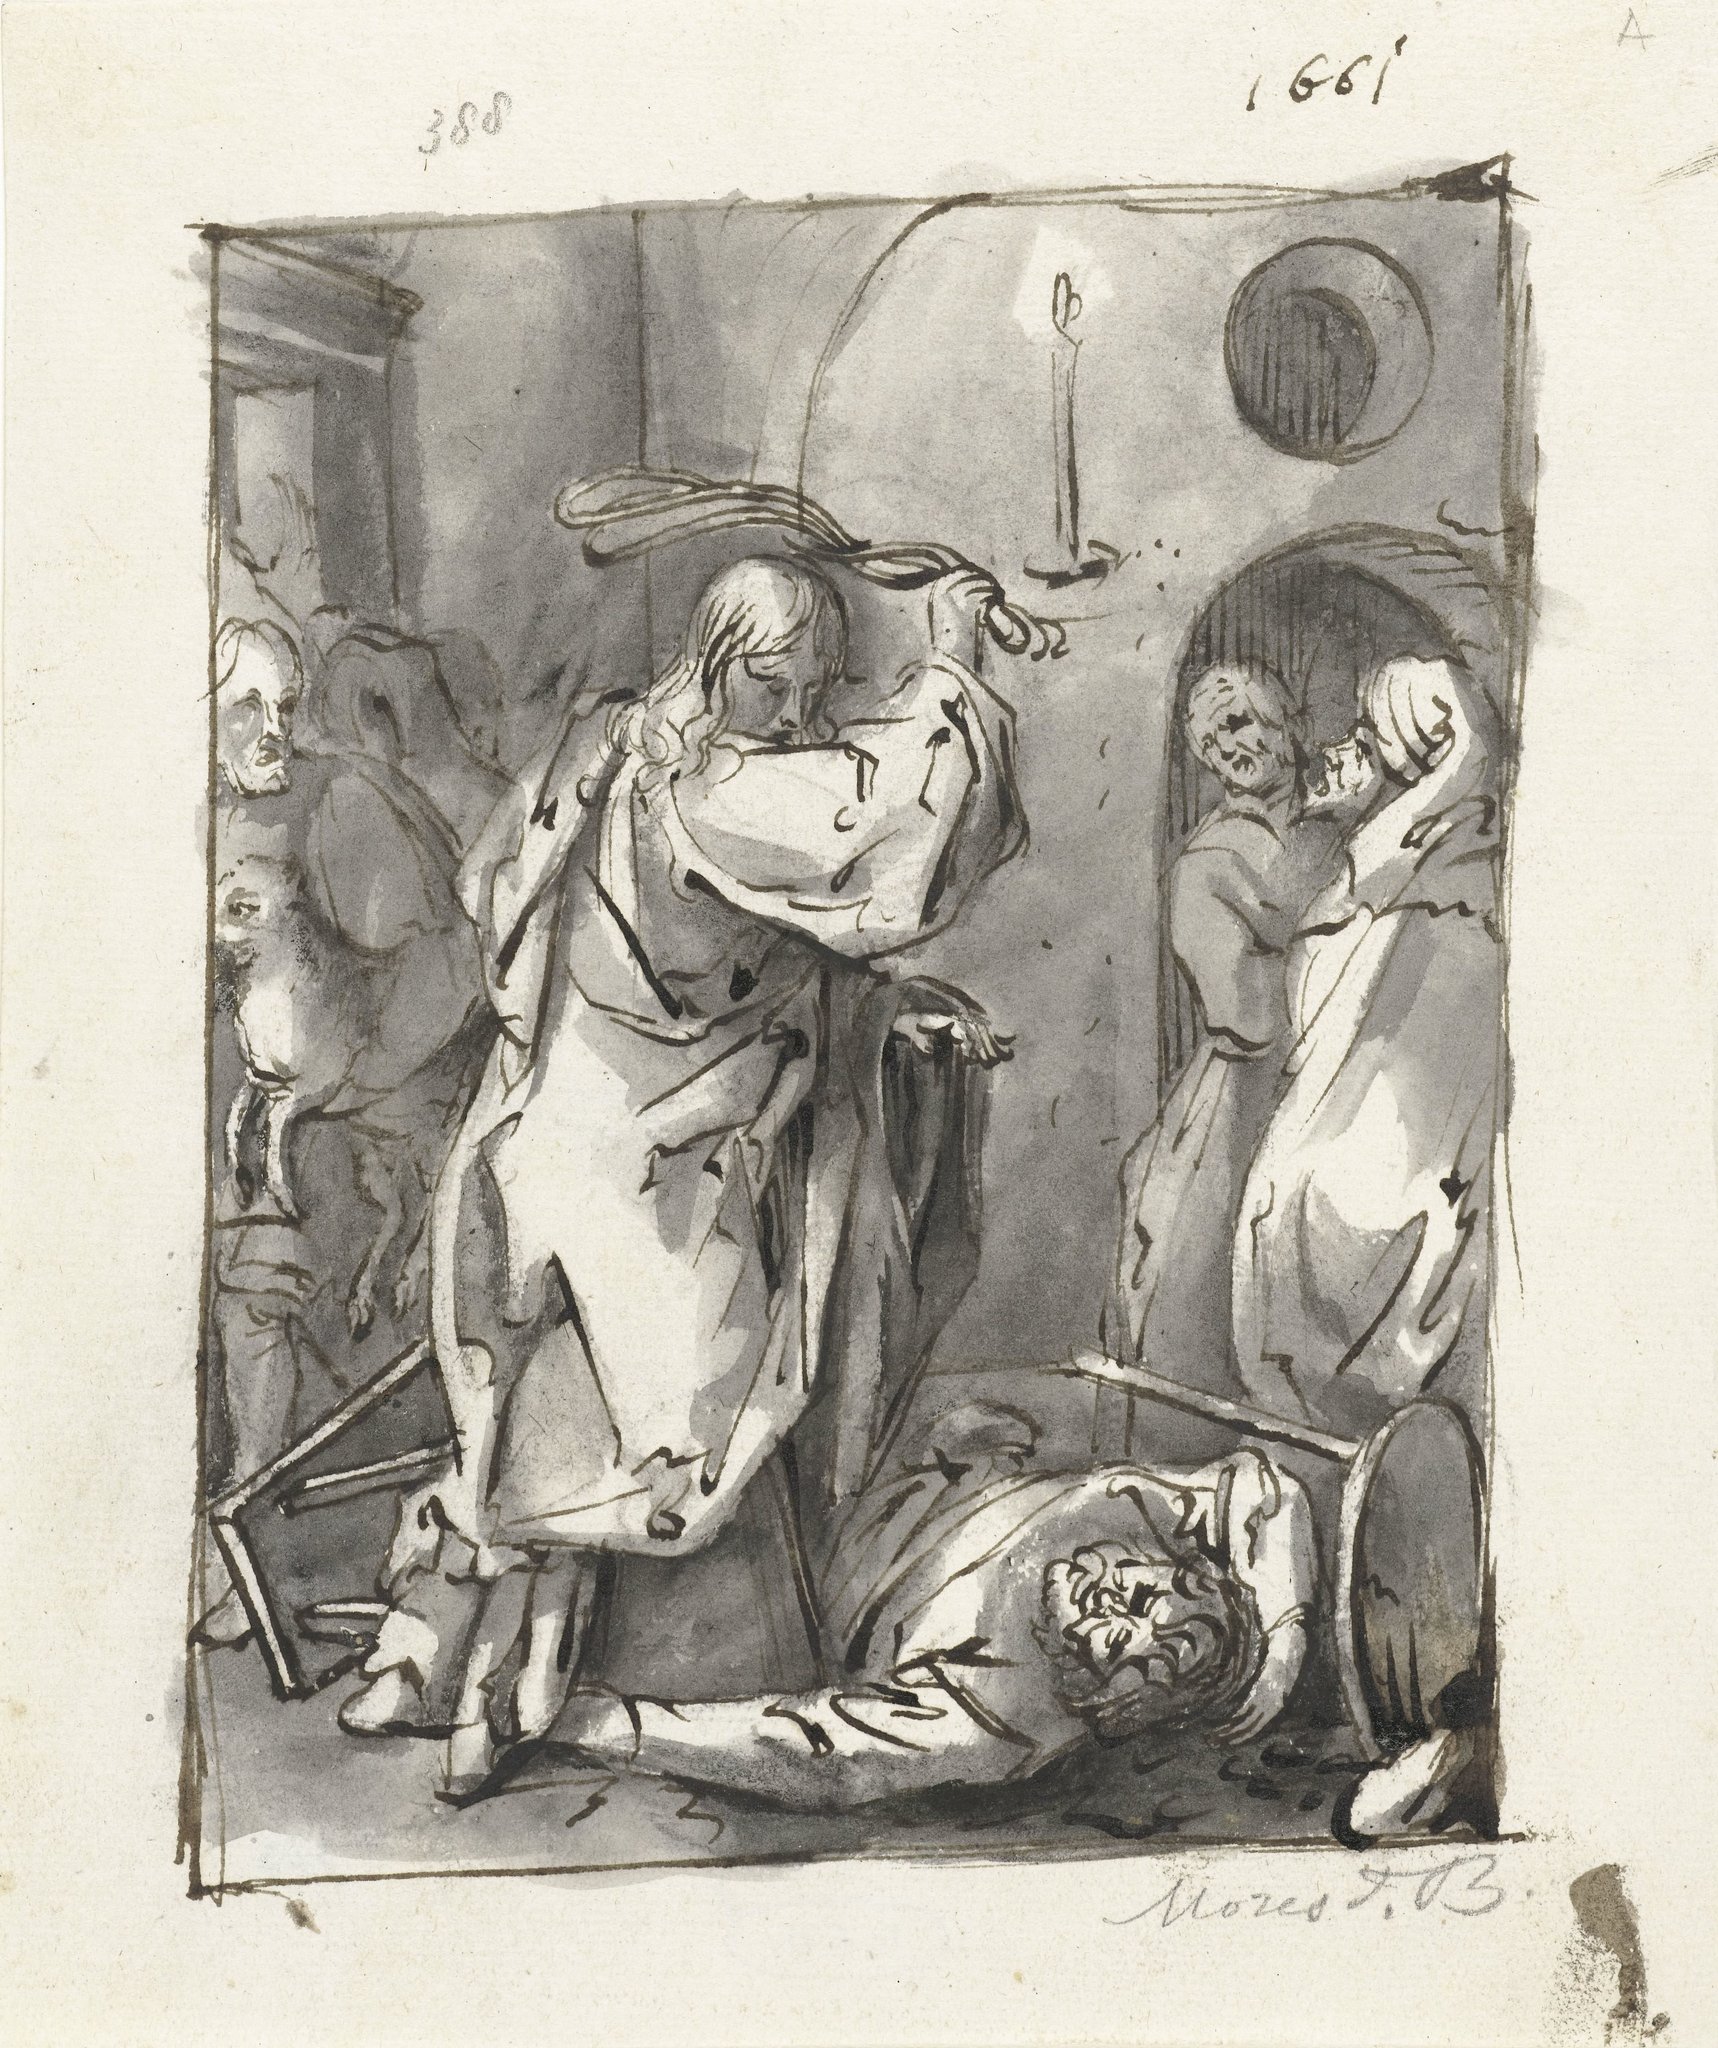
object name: drawing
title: Tempelreiniging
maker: moses ter borch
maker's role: draughtsman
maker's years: 1645-1667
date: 1661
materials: chalk, ink, paper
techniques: brush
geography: zwolle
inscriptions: date: ‘1661’, annotation: ‘Mozes T.B. / A’, annotation: ‘Dürer / B VII 119-23’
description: Kopie naar houtsnede uit de prentserie 'De kleine Passie' van Albrecht Dürer.